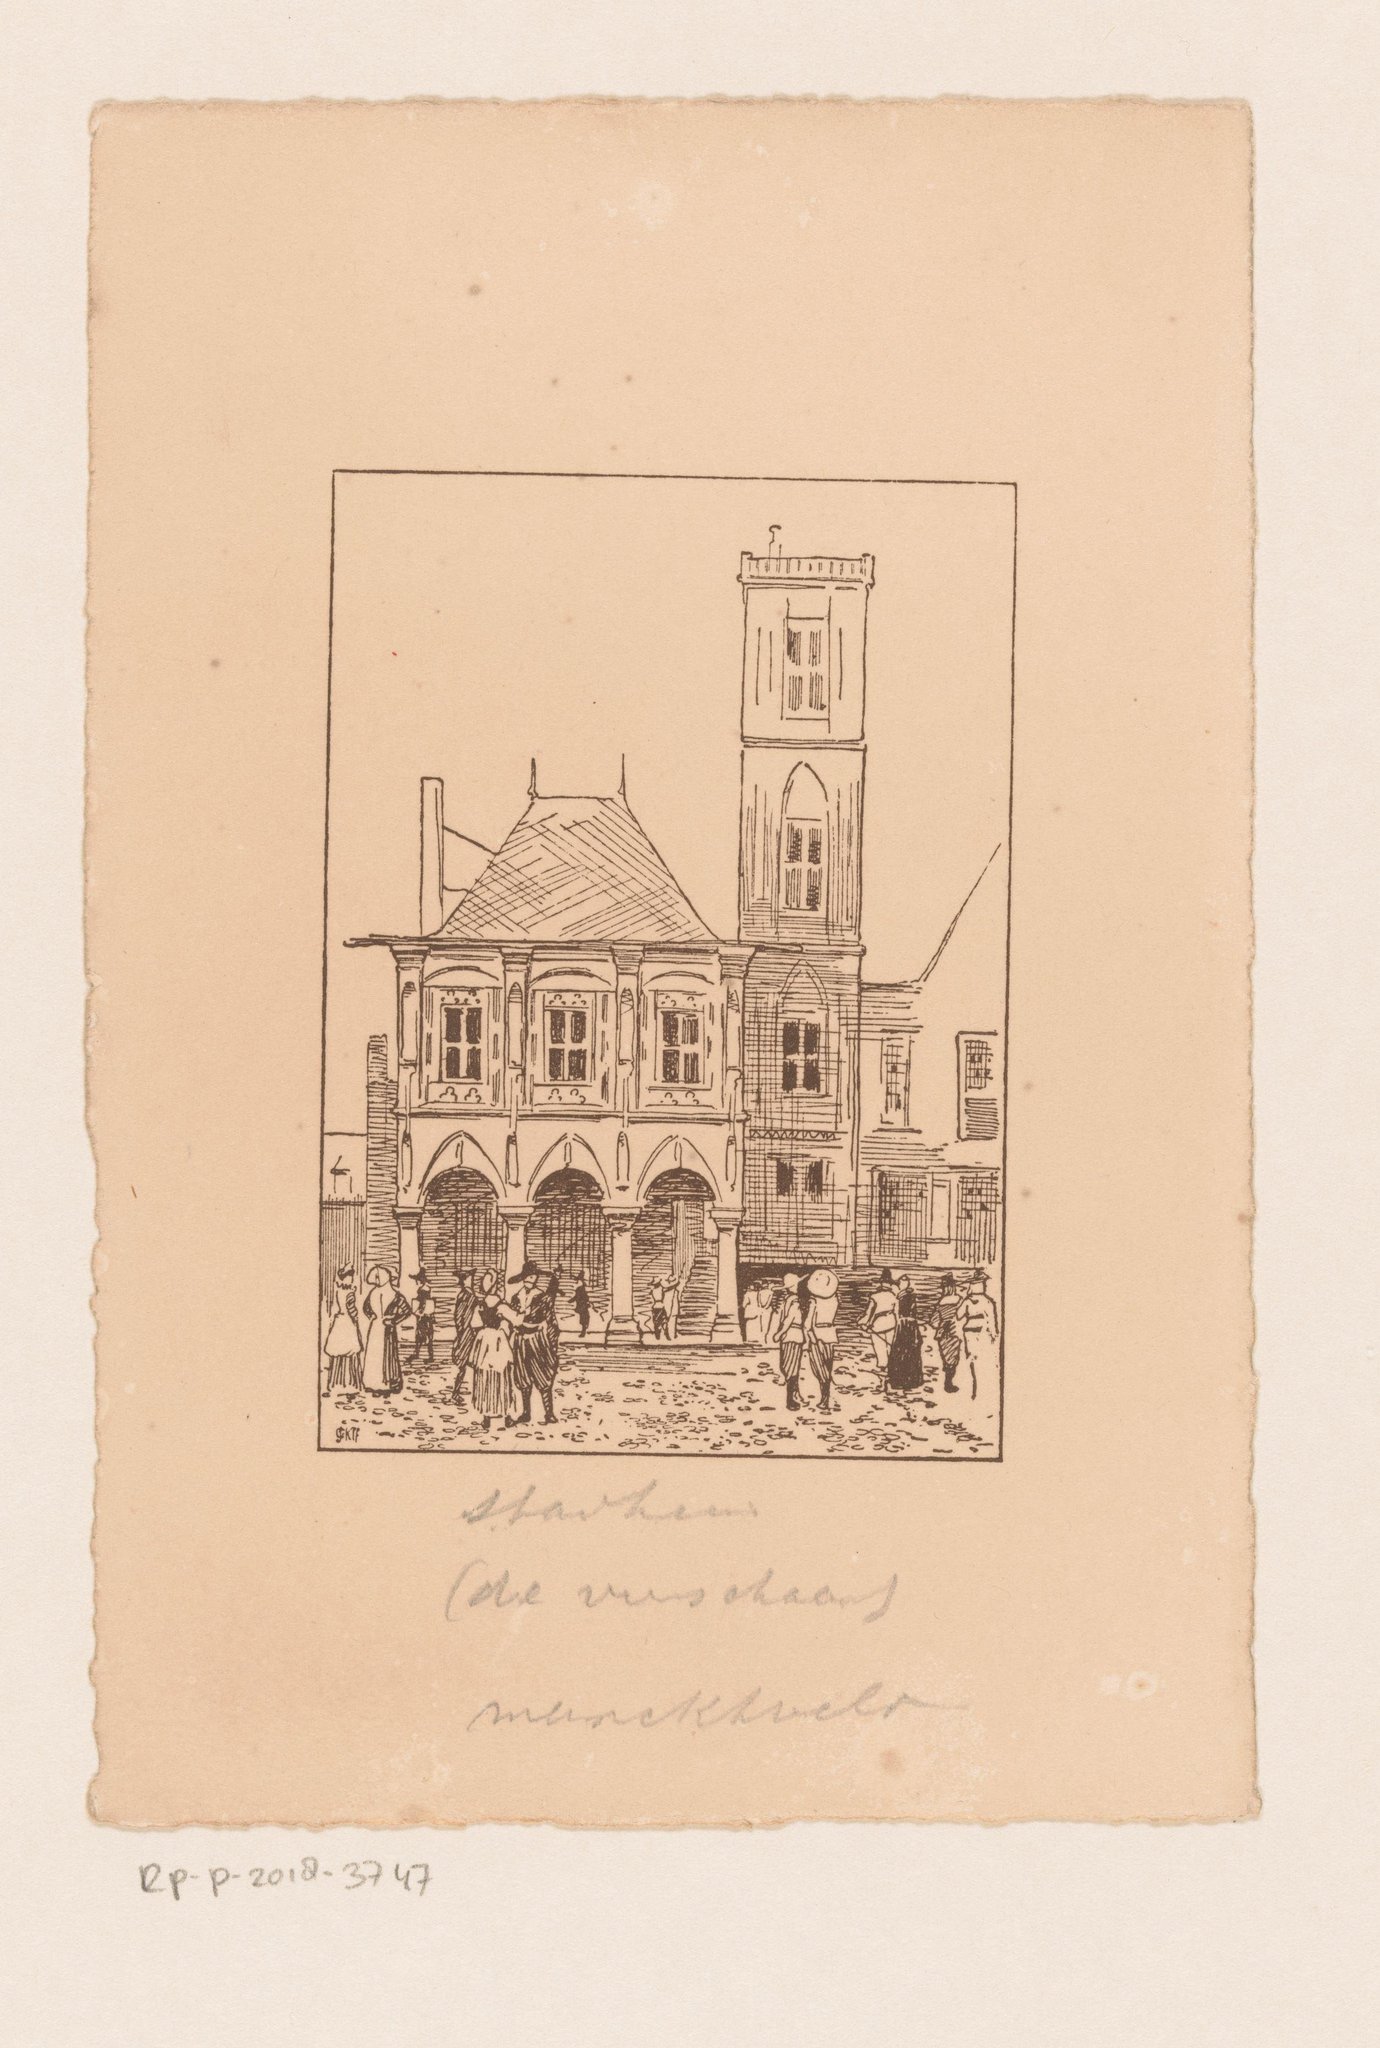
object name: print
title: Gezicht op het Oude Stadhuis in Amsterdam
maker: Anonymous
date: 1825-1900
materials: paper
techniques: lithograph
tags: city-view, and landscape with man-made constructions, amsterdam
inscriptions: monogram: ‘G.K.T.F.’